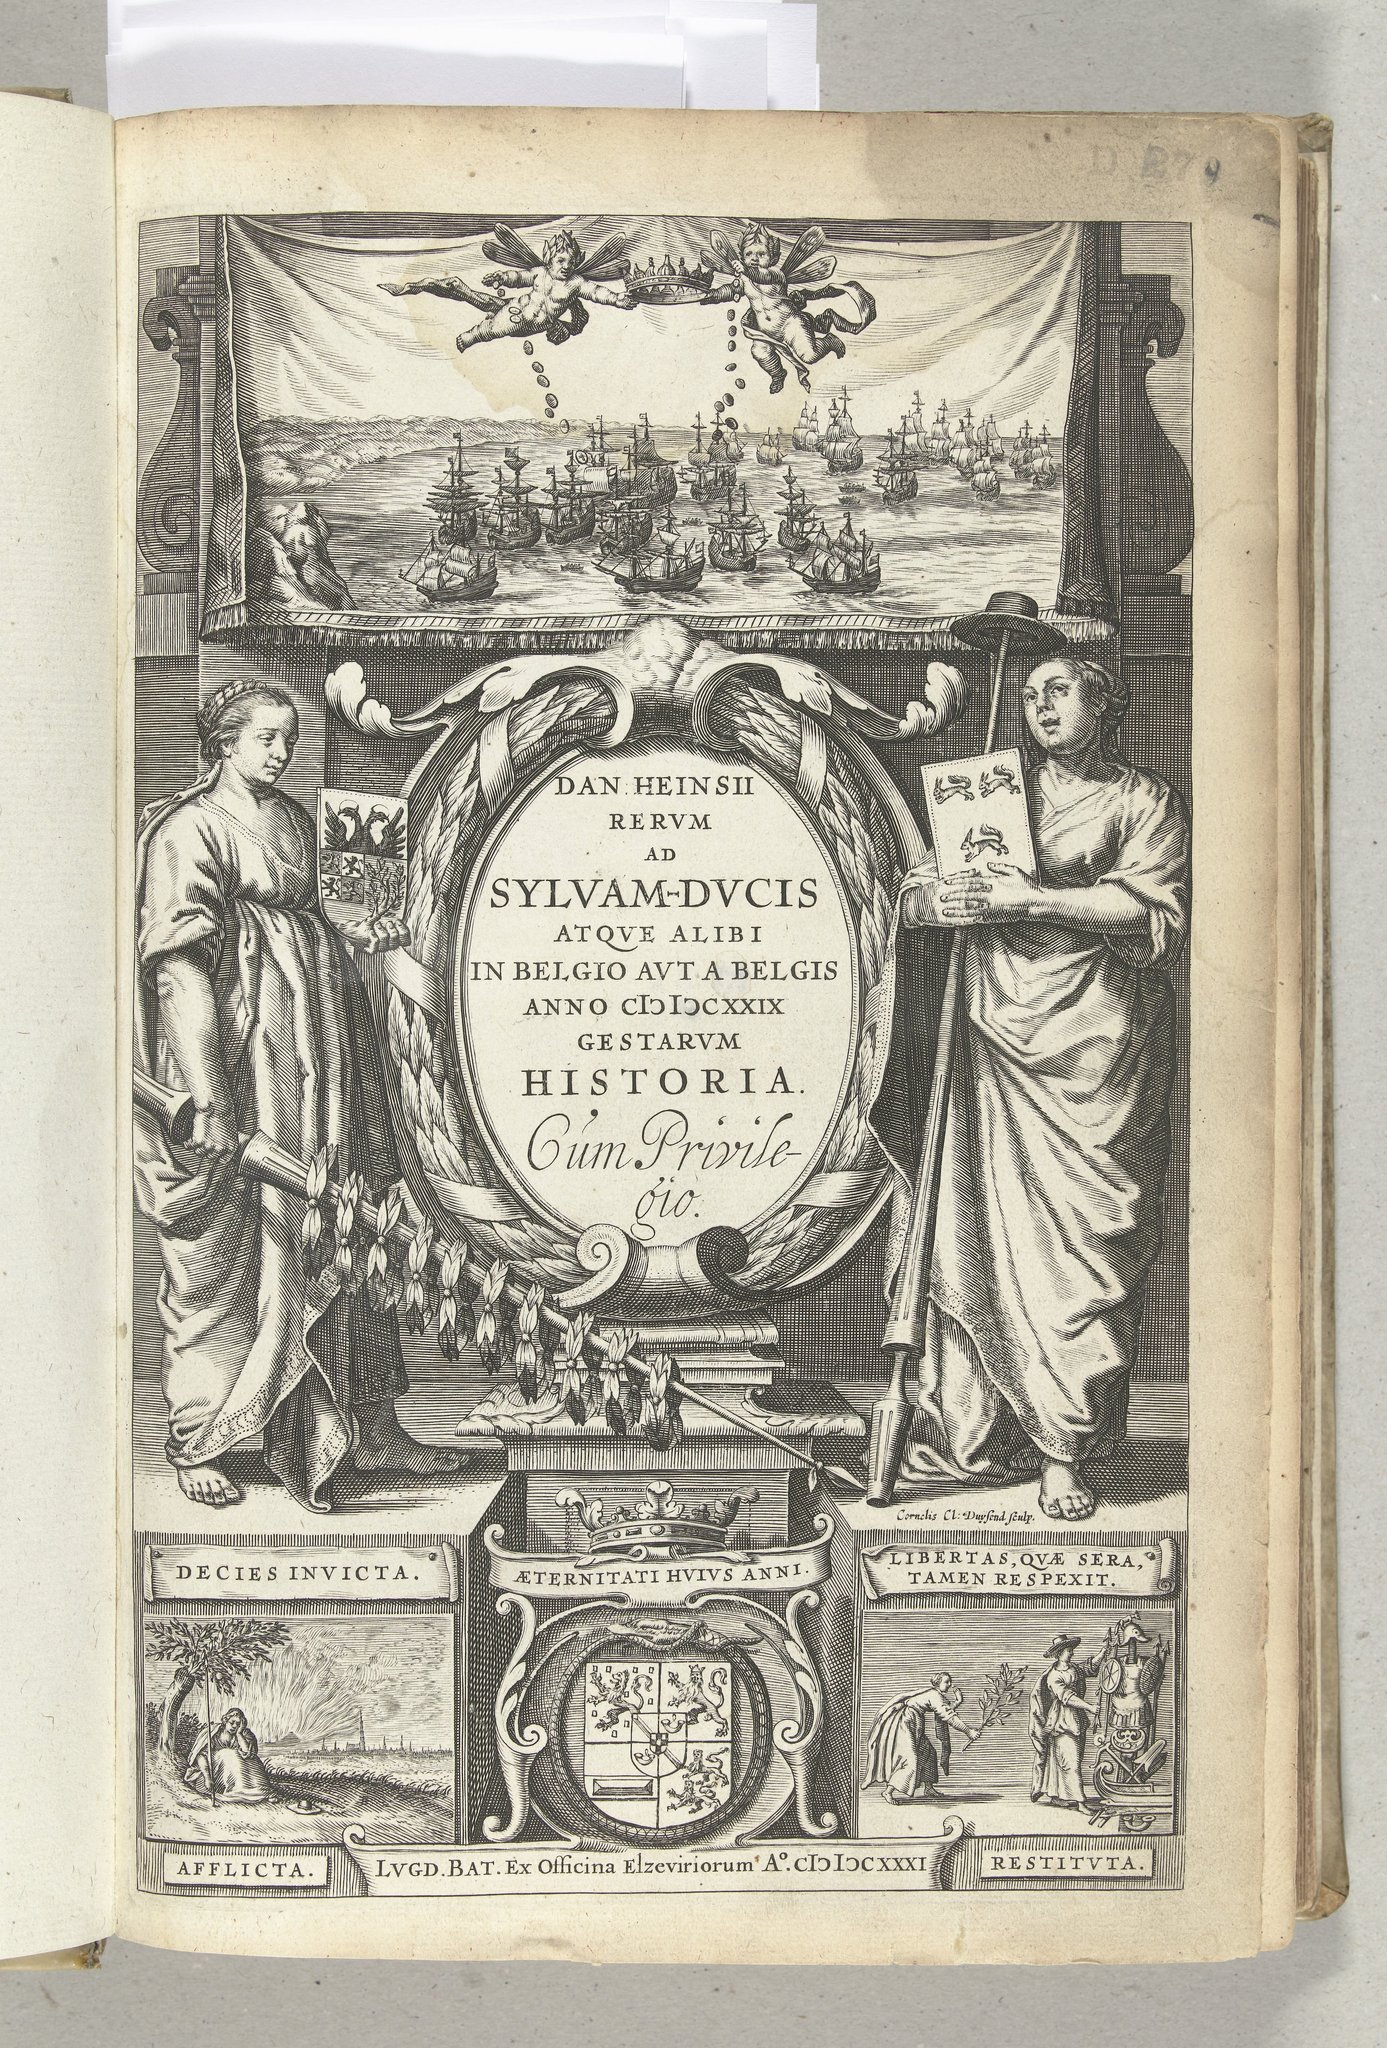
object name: titelblad, titelpagina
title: Titelpagina van Daniel Heinsius, Rerum ad Sylvam-Ducis atque alibi in Belgio aut a Belgio anno 1629 gestarum historia, 1631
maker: cornelis claesz. duysend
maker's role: print maker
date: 1631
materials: paper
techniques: engraving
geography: leiden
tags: delft, the hague, frederick henry (prince of orange), personification of a city, town-patron(ess), den bosch, capture of the spanish treasure fleet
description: Allegorische titelpagina van Daniel Heinsius, Rerum ad Sylvam-Ducis atque alibi in Belgio aut a Belgio anno 1629 gestarum historia, het verslag van het beleg en de verovering van Den Bosch door het Staatse Leger onder Frederik Hendrik, tussen 1 mei en 17 september 1629. Twee staande personificaties, links de stedenmaagd van Den Bosch, rechts de stedenmaagd van Wesel met de vrijheidslans met hoed. Bovenaan een voorstelling van schepen voor een kust, waarschijnlijk de verovering van de Zilvervloot, onderaan het wapen van Frederik Hendrik tussen twee emblemen.